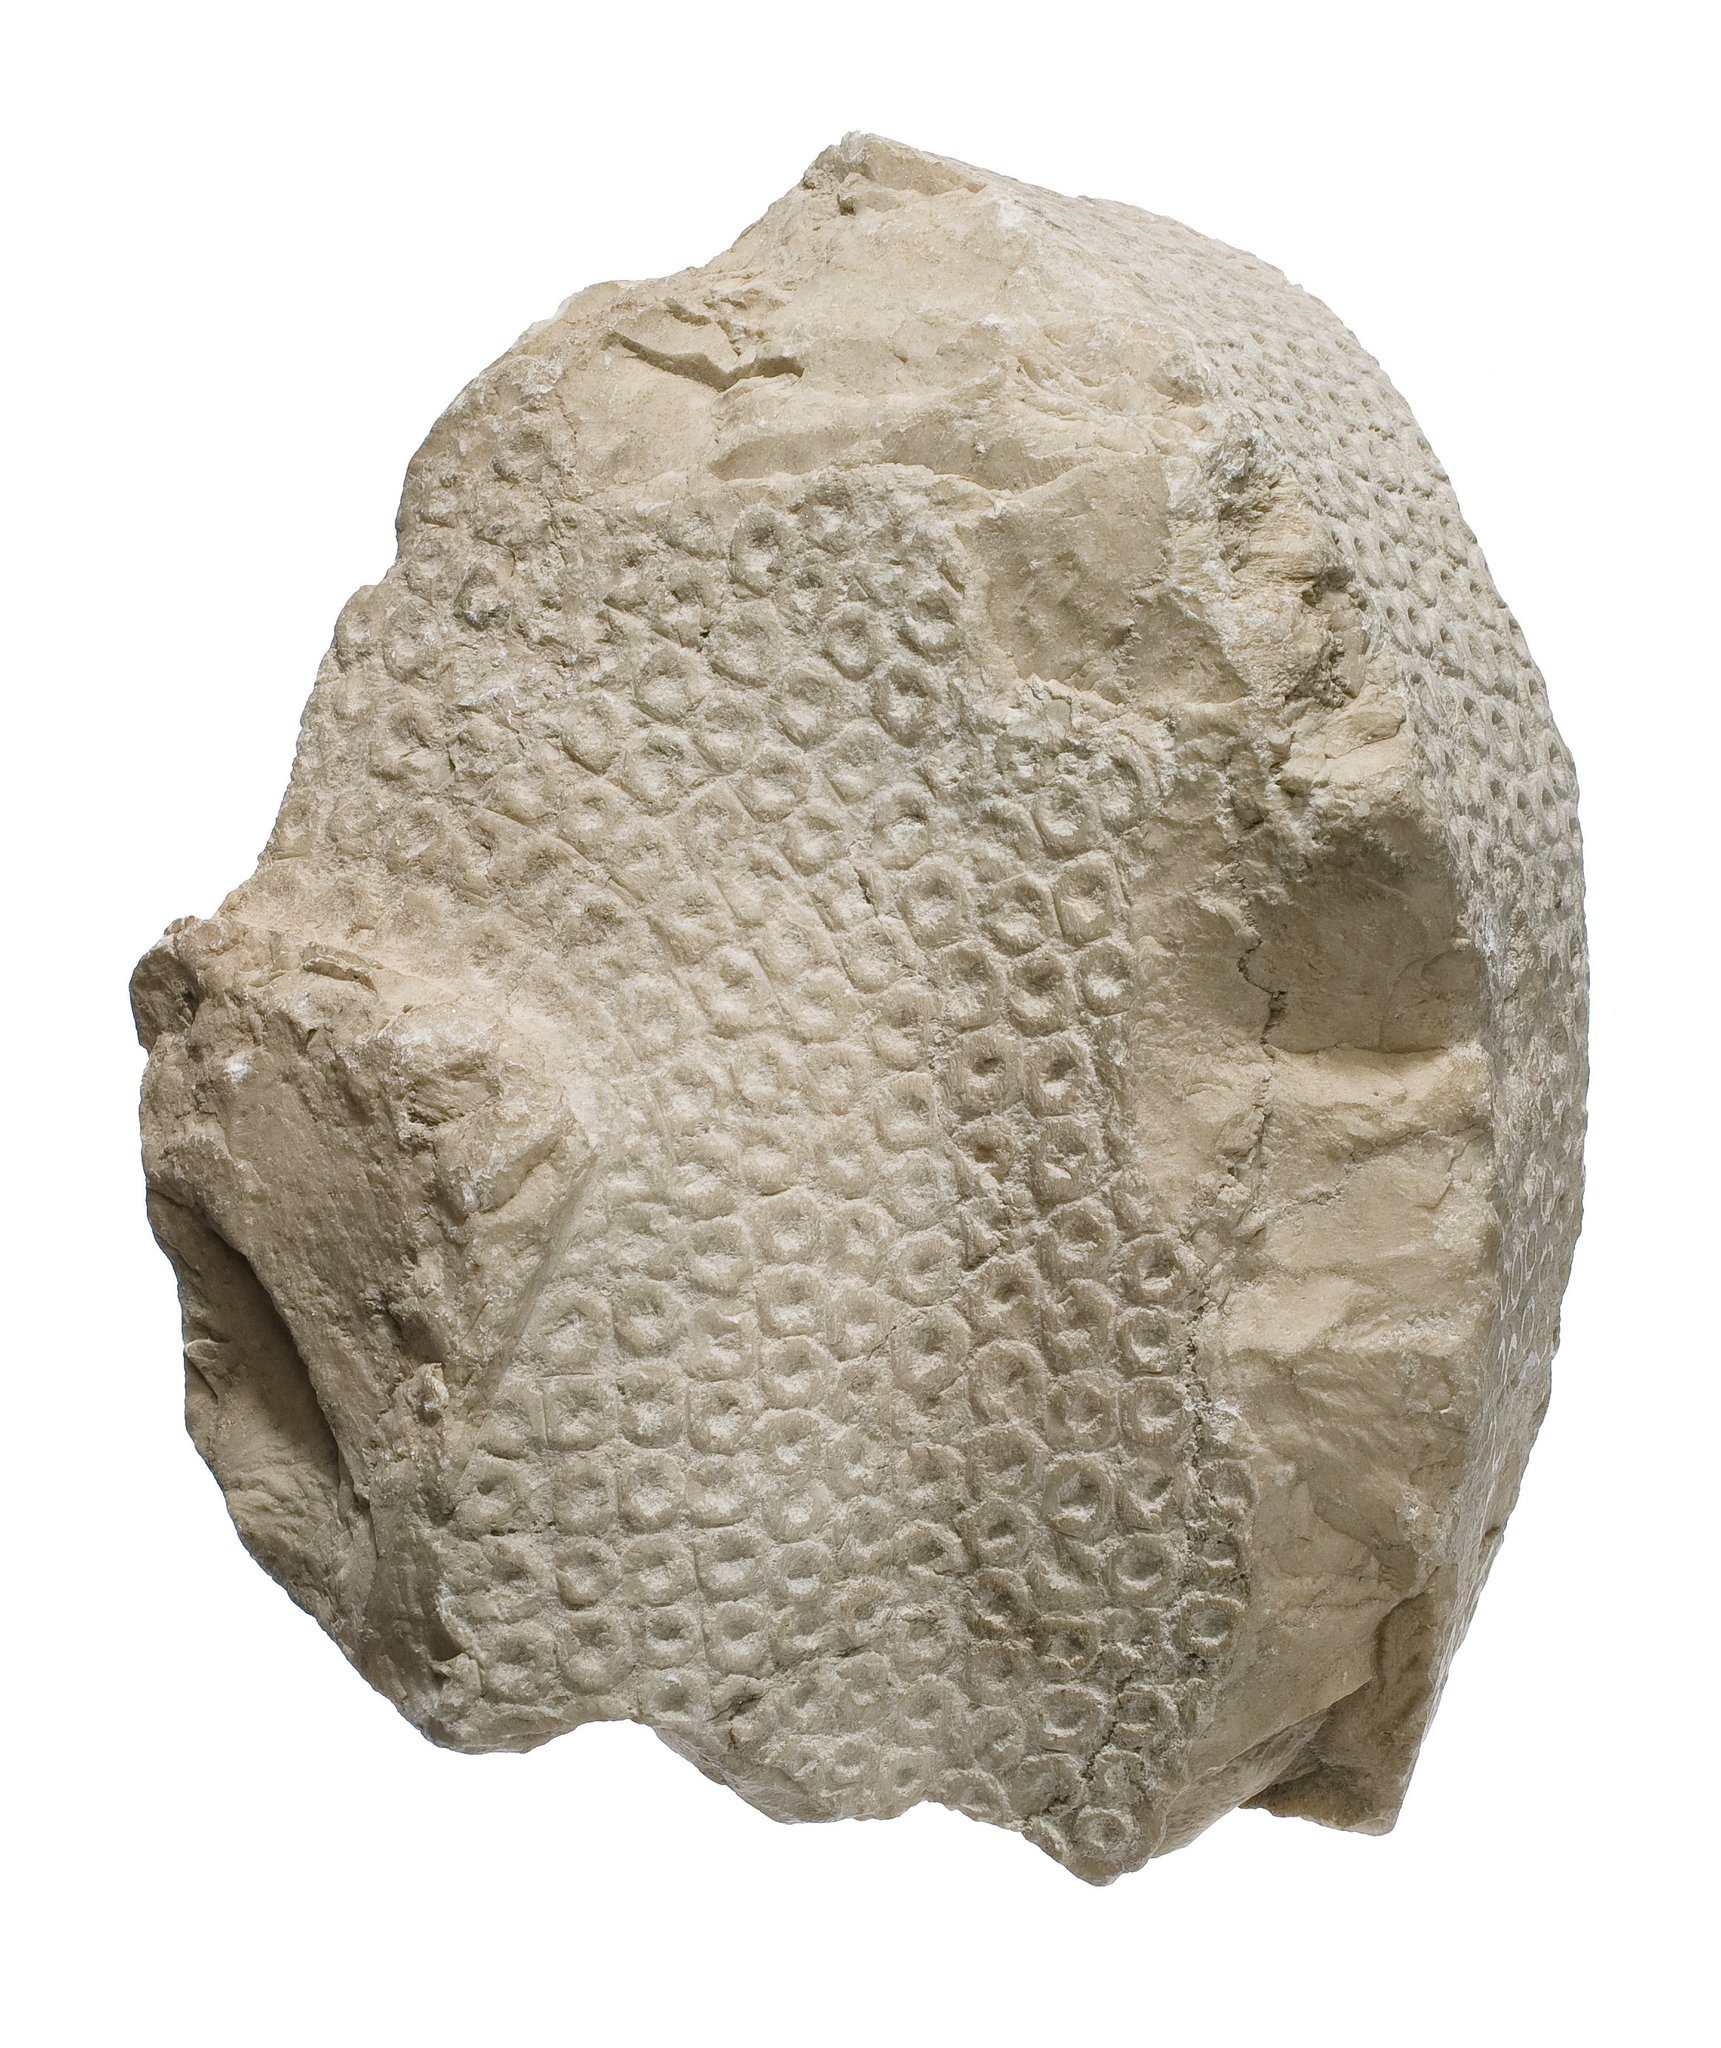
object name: head of akhenaten, blue crown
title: Blue crown from head of Akhenaten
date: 1353-1336 BCE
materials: limestone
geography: egypt